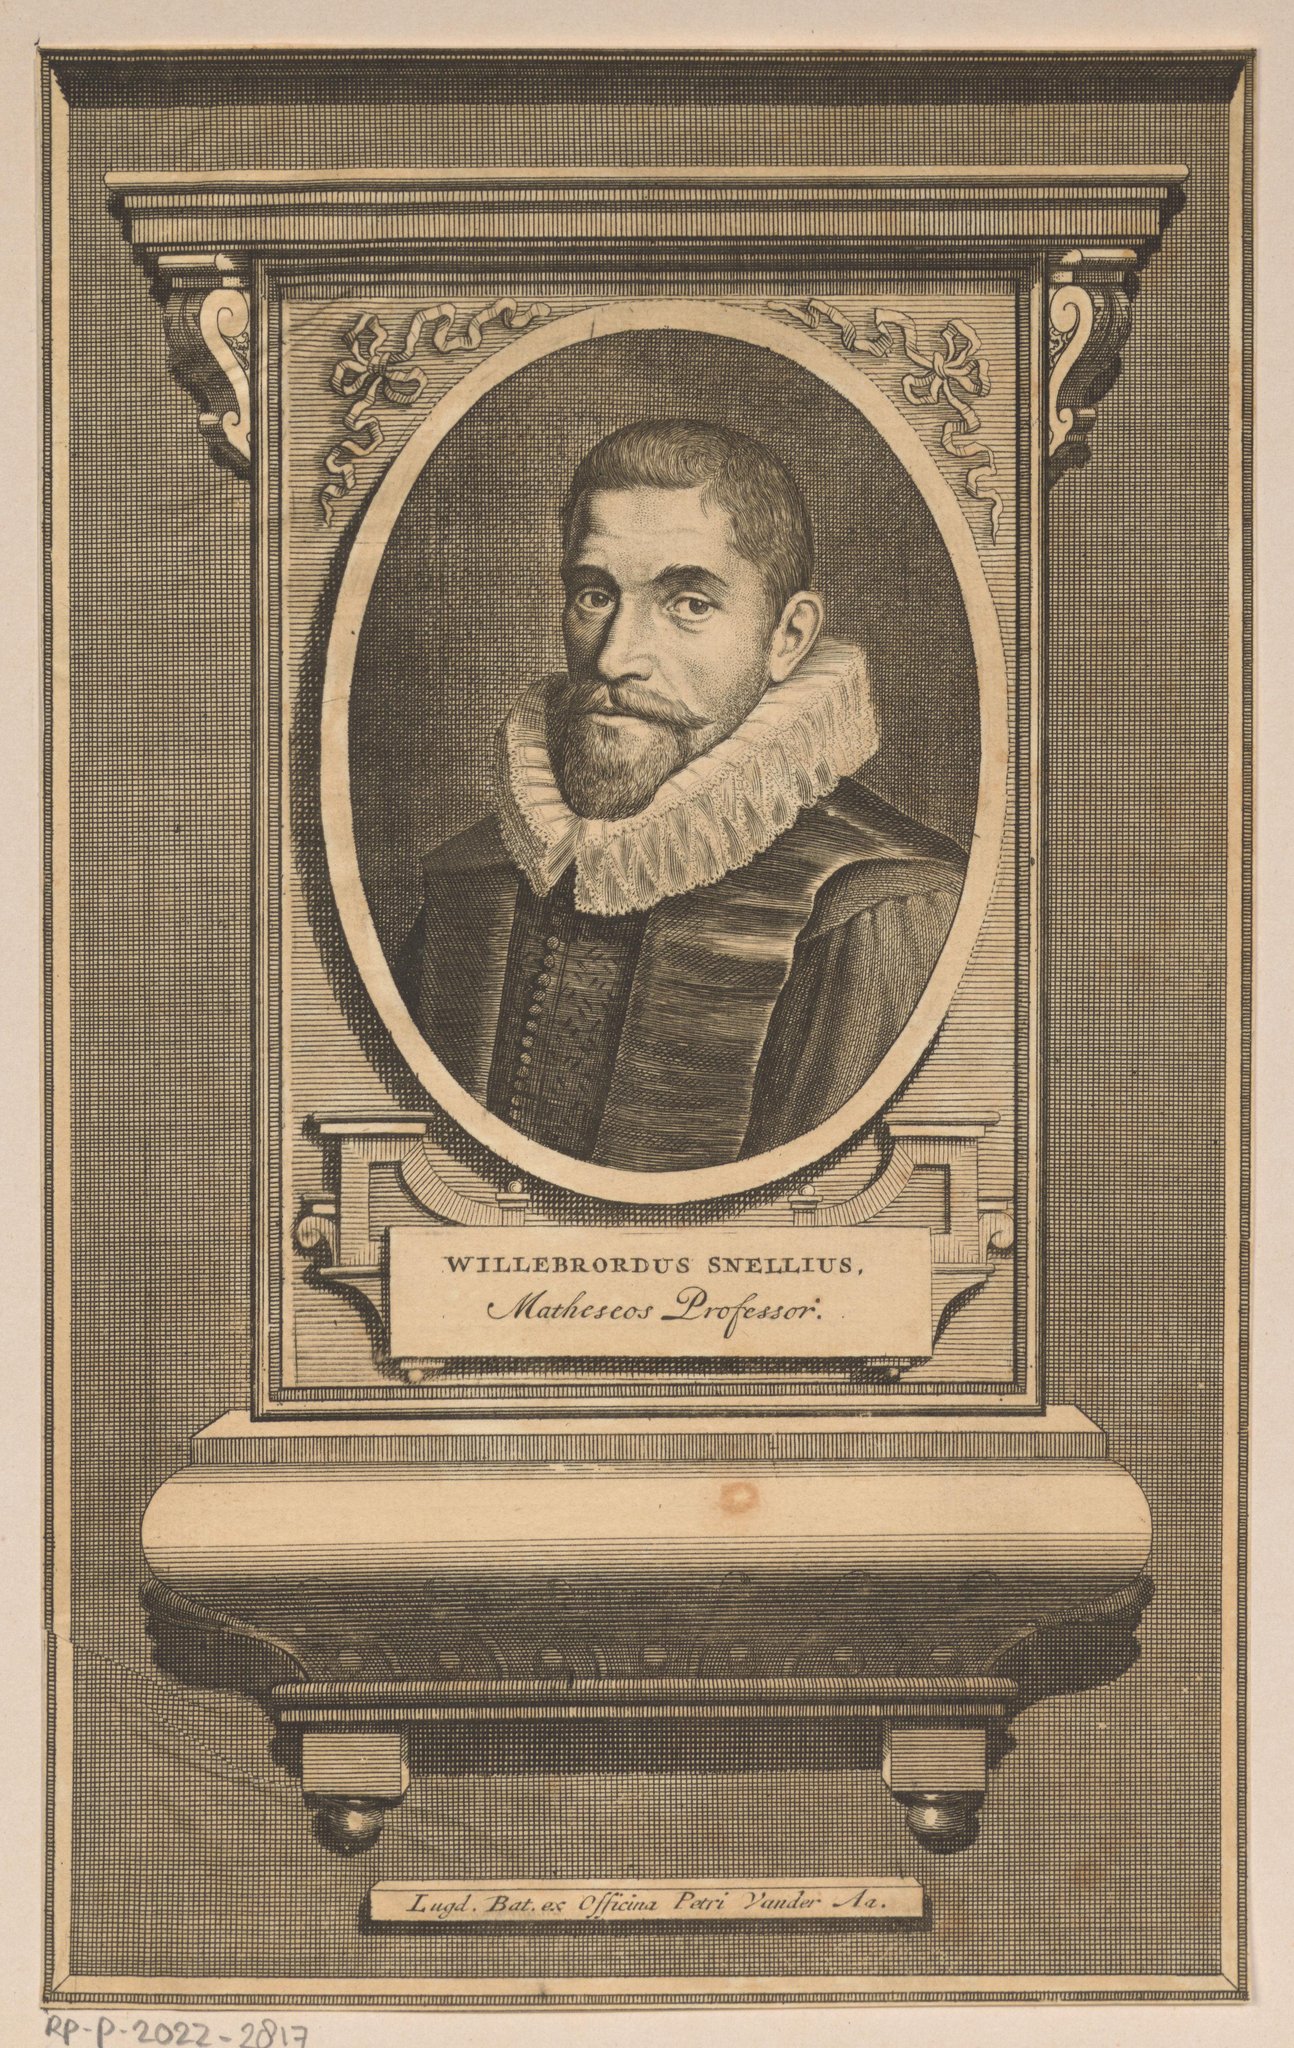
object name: print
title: Beroemde mannen aan de universiteit van Leiden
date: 1716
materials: paper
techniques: engraving, etching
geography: leiden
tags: historical persons, professor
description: Prent vermoedelijk eerder gebruikt in een serie uit 1614, zie Van Someren, 1888.